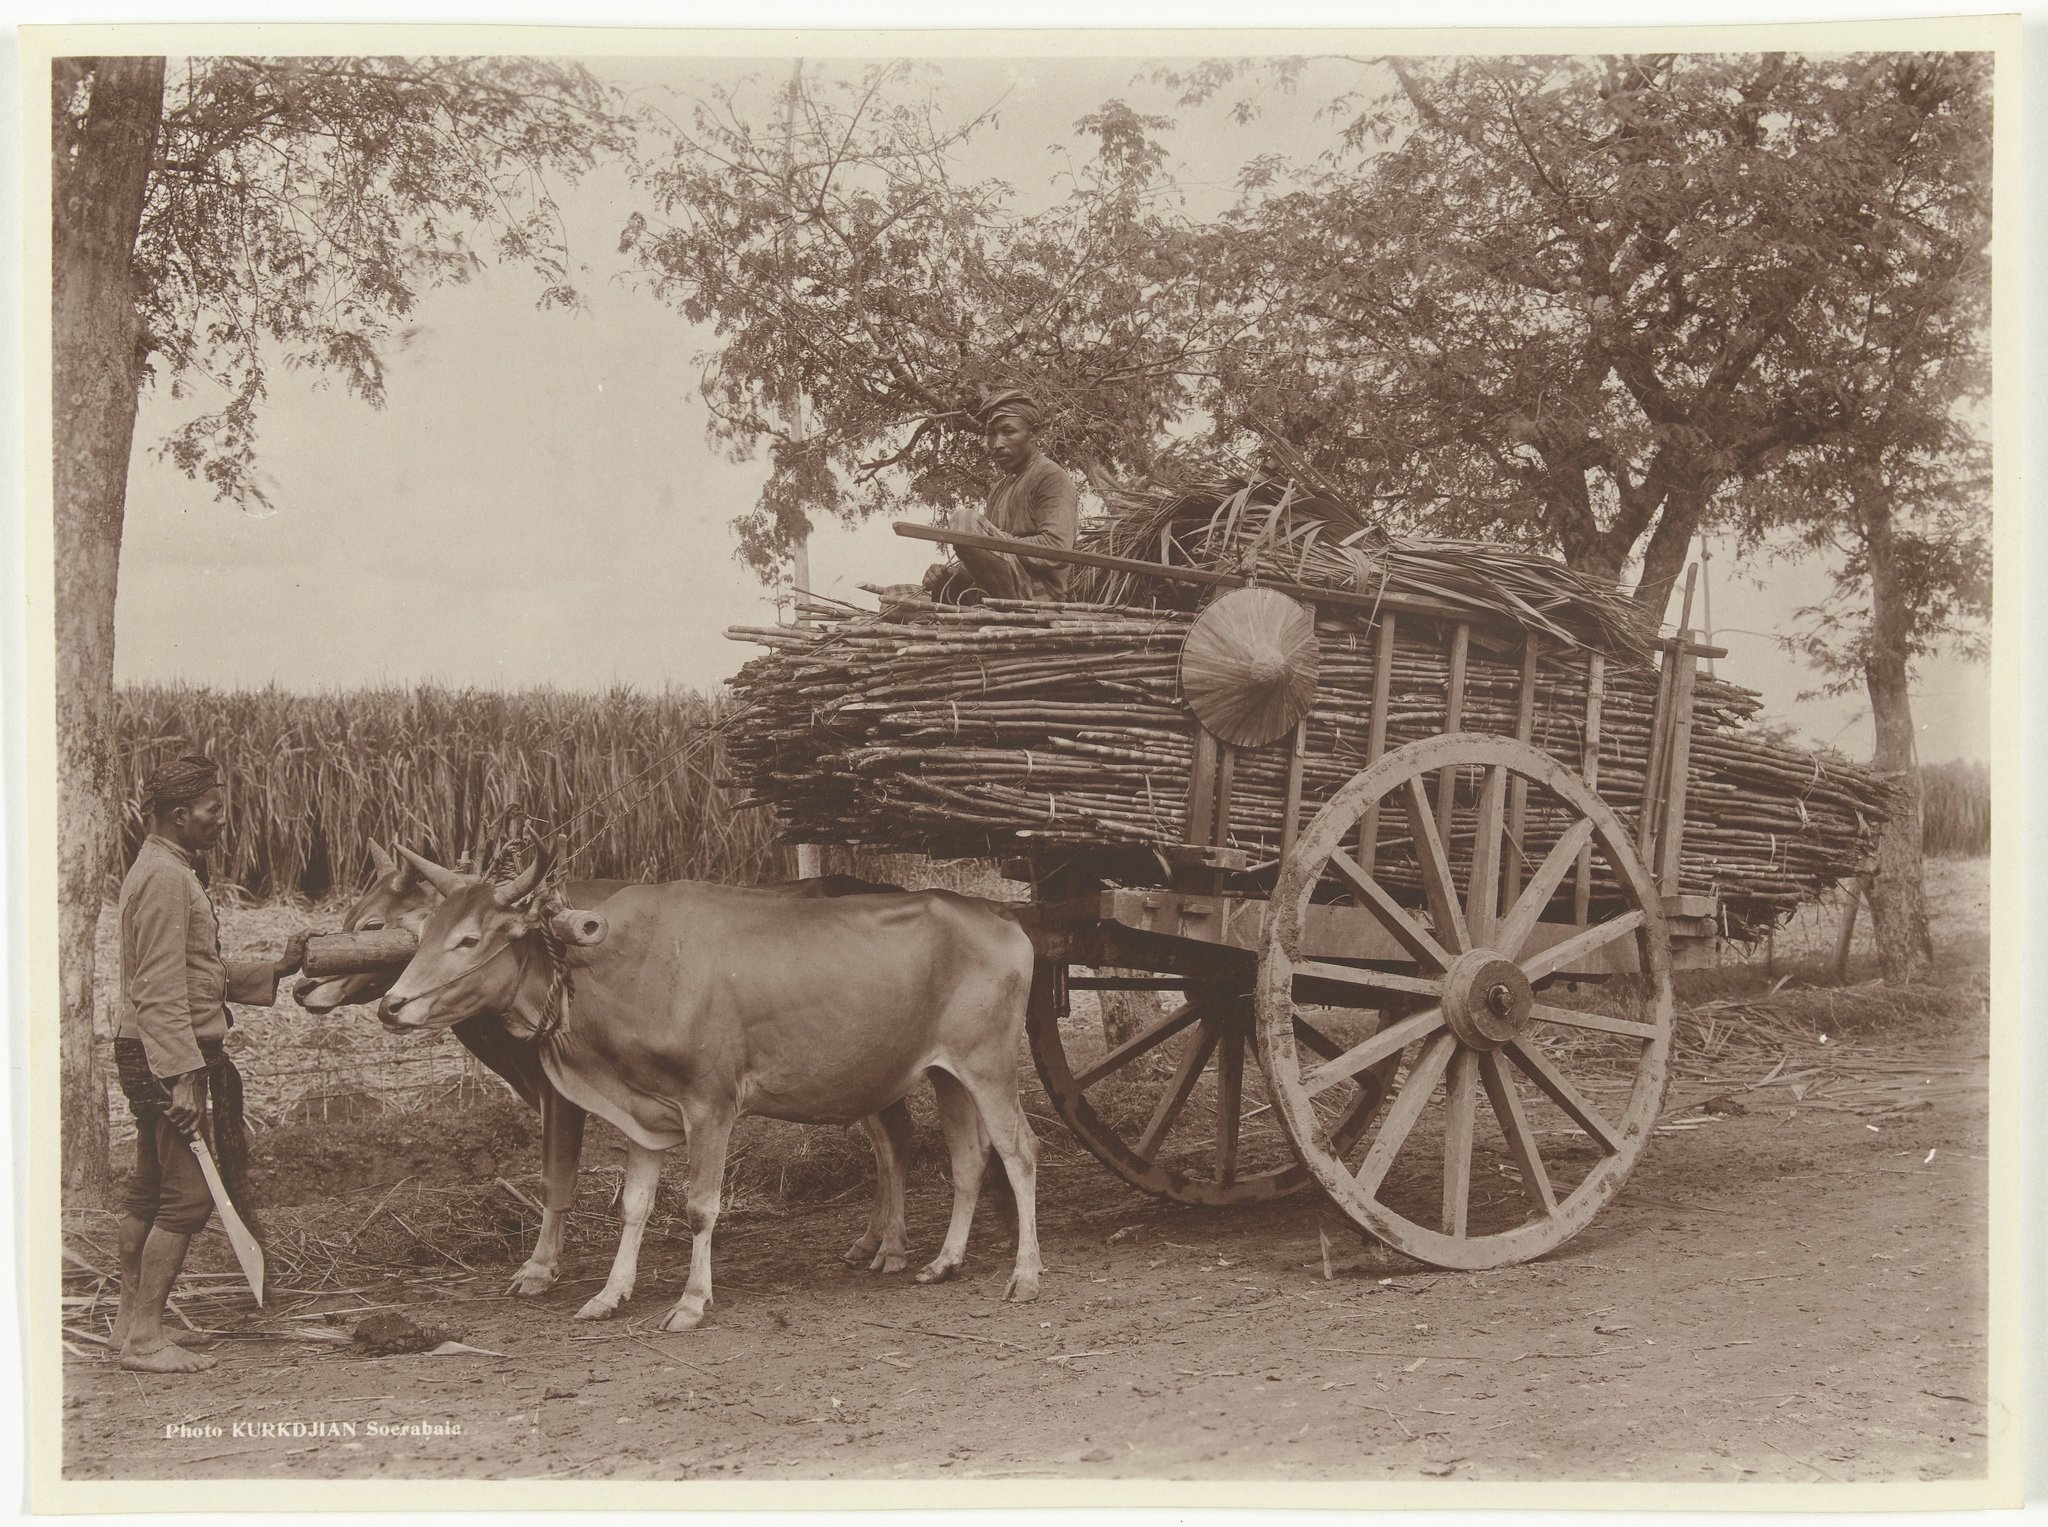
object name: photograph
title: Riettransport, voormalig Nederlands-Indië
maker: onnes kurkdjian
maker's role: fotograaf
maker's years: 1851-1903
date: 1890-1911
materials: paper, photographic support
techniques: gelatin silver print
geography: dutch east indies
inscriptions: name: ‘Photo Kurkdjian Soerabaia’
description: Twee mannen zijn bezig met het vervoeren van riet met een wagen getrokken door twee ossen (voormalig Nederlands-Indië). Een man zit op het riet op de wagen en de ander, met een kapmes in de hand, staat voor de ossen die de wagen trekken.